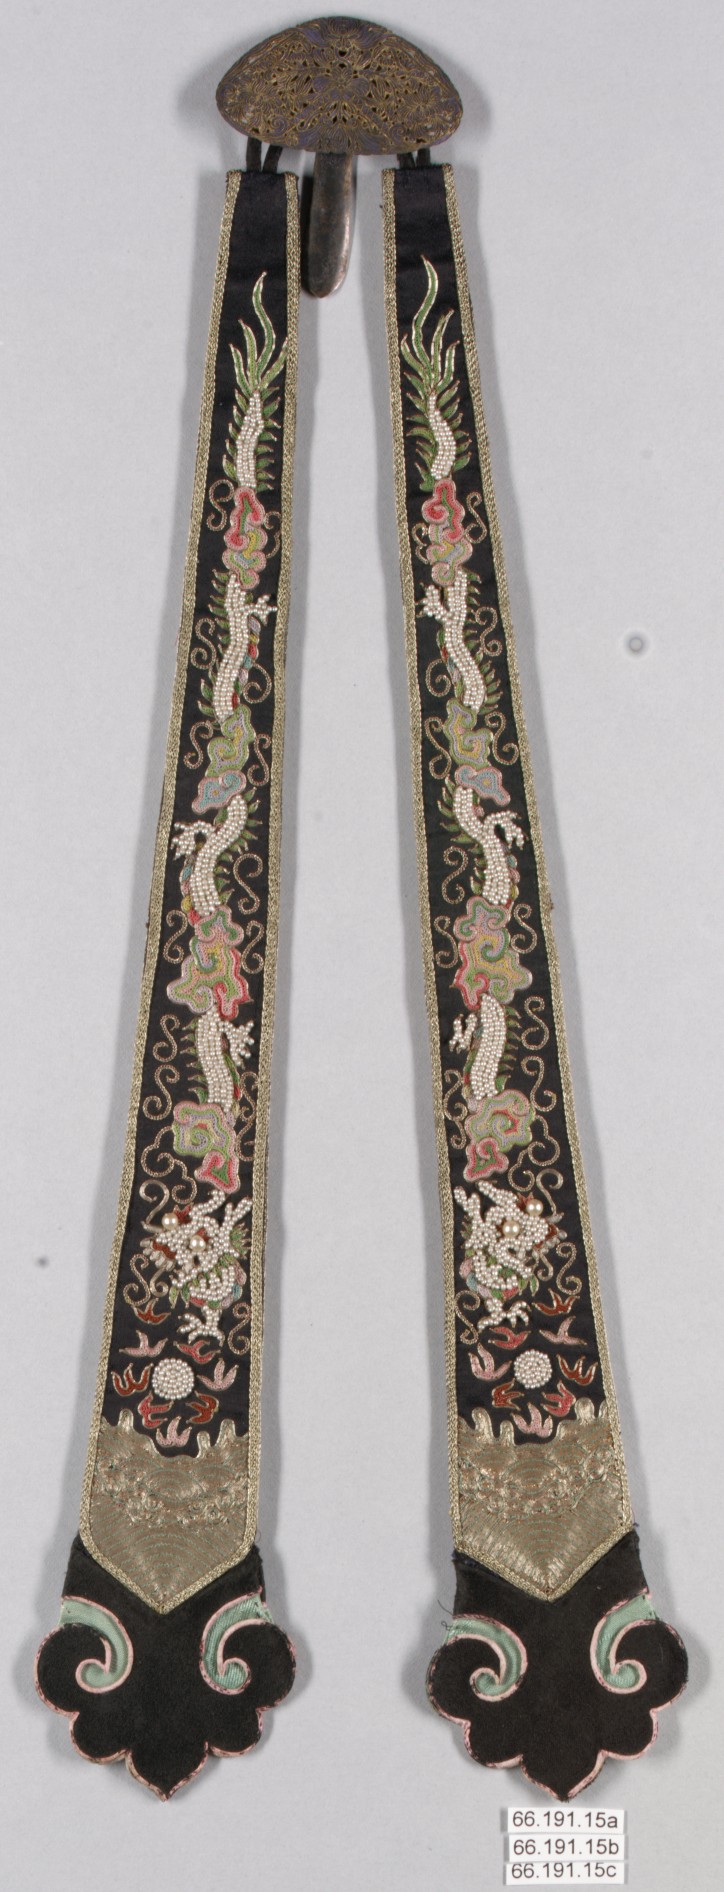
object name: hat ornament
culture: chinese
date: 1644-1911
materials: metal thread, pearl, silk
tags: dragons